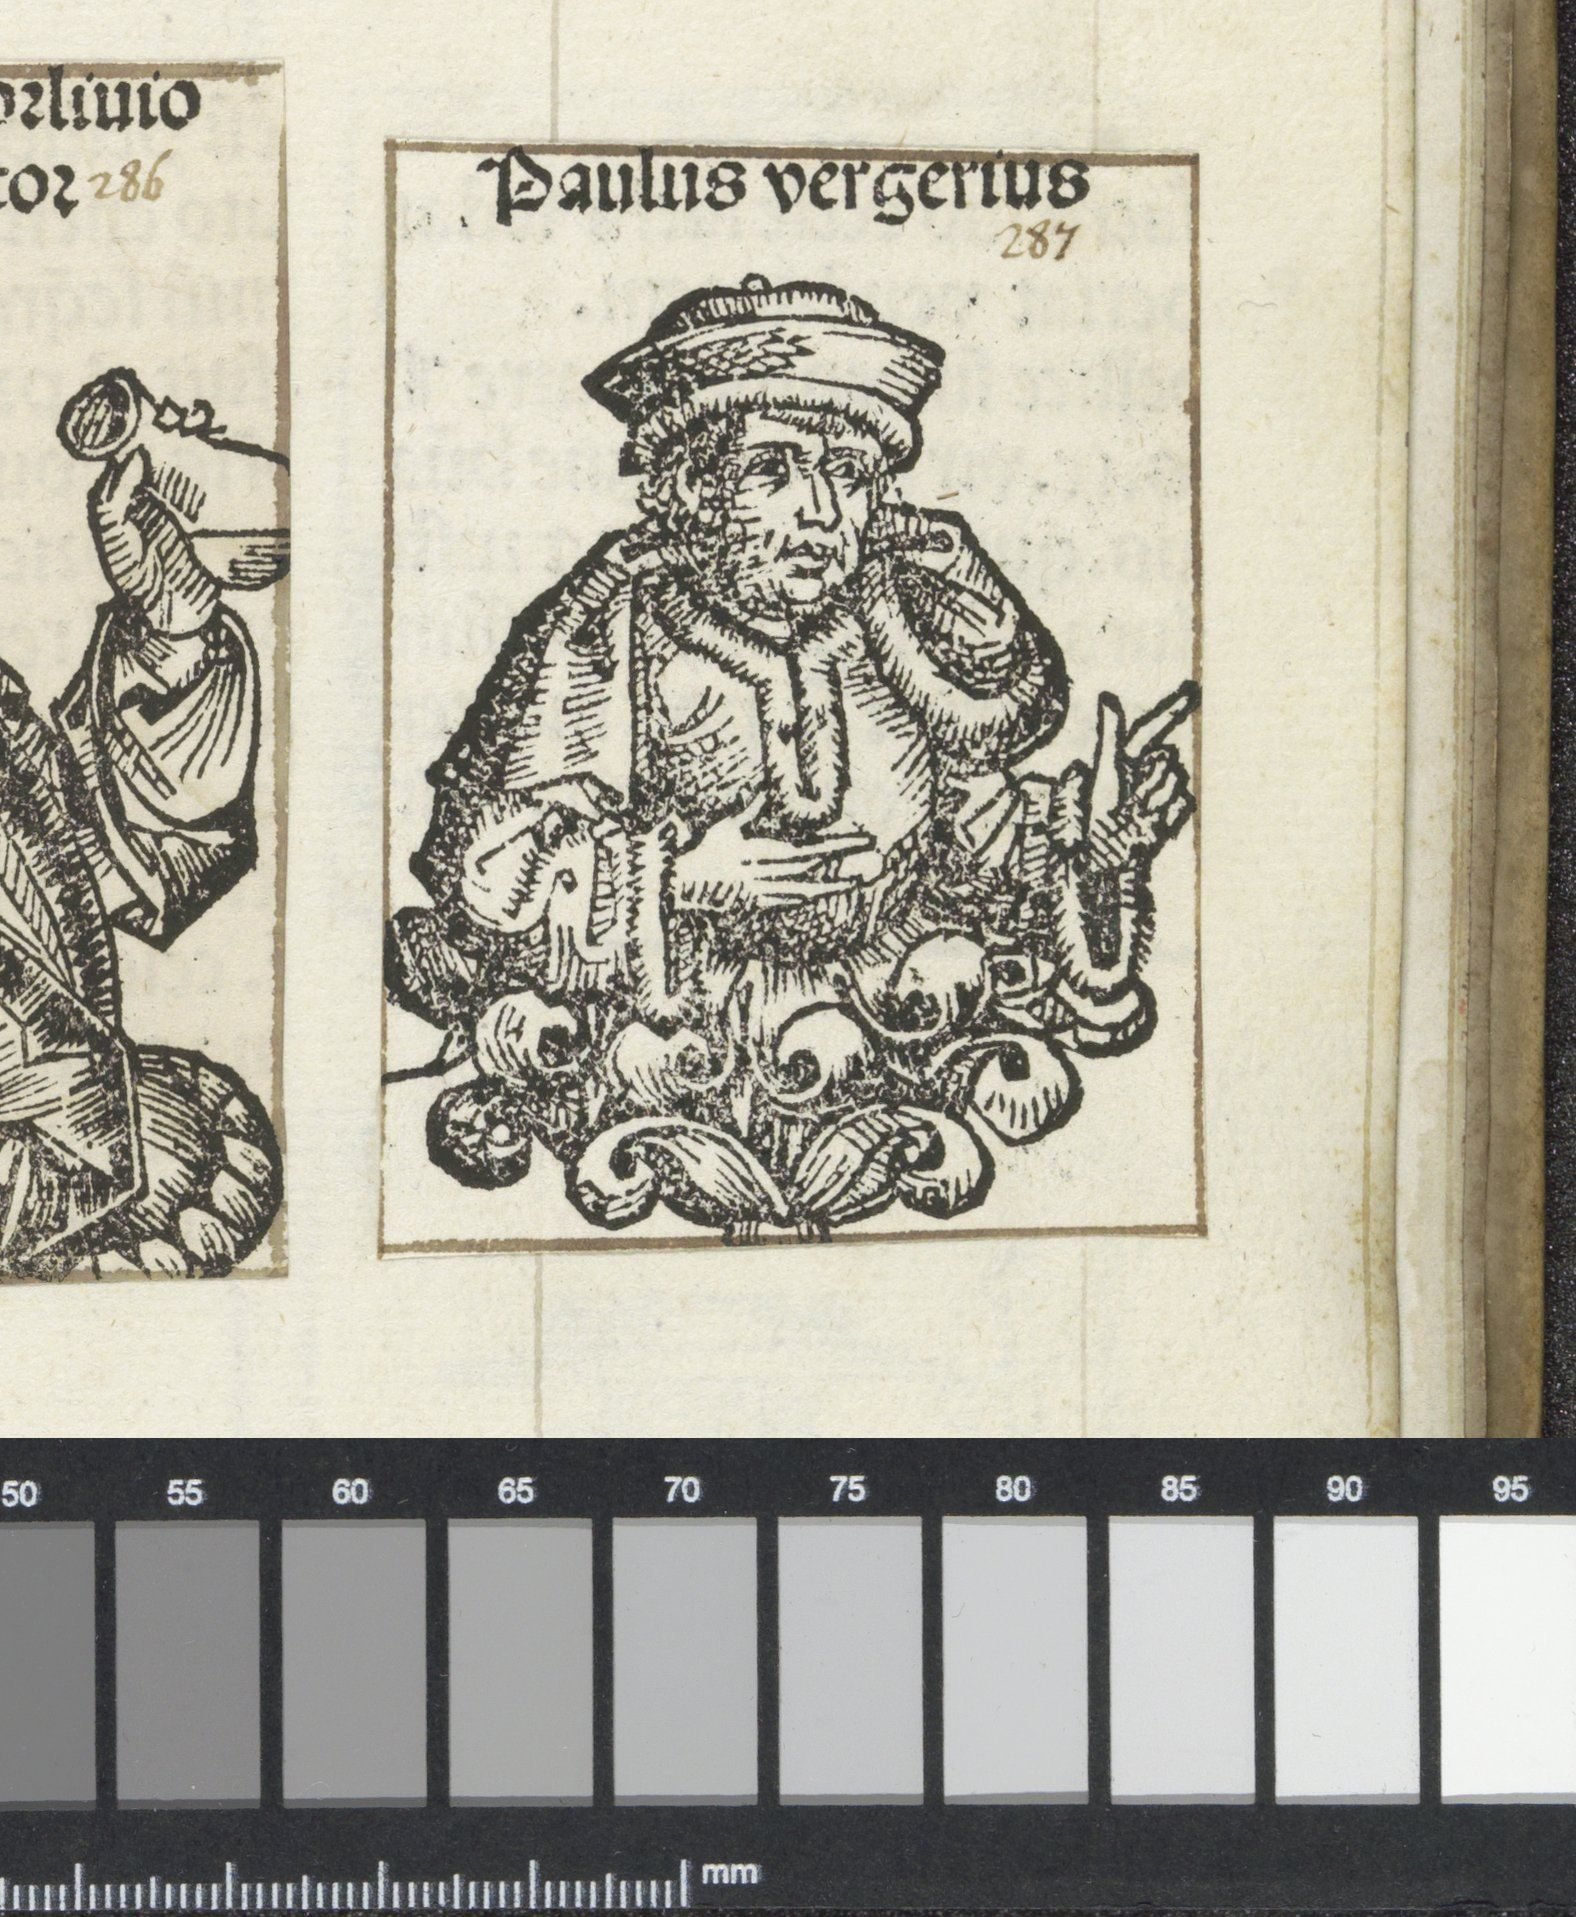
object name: album leaf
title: Liber Chronicarum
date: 1493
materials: paper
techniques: letterpress printing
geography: nuremberg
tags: pietro paolo vergerio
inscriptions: inscription: ‘287’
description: De houtsnede wordt herhaaldelijk gebruikt als boekillustratie in de Liber Chronicarum (of Neurenbergkroniek) van Hartmann Schedel, verschenen in het Latijn en Duits in 1493. Zie de Latijnse uitgave, folio 244v.